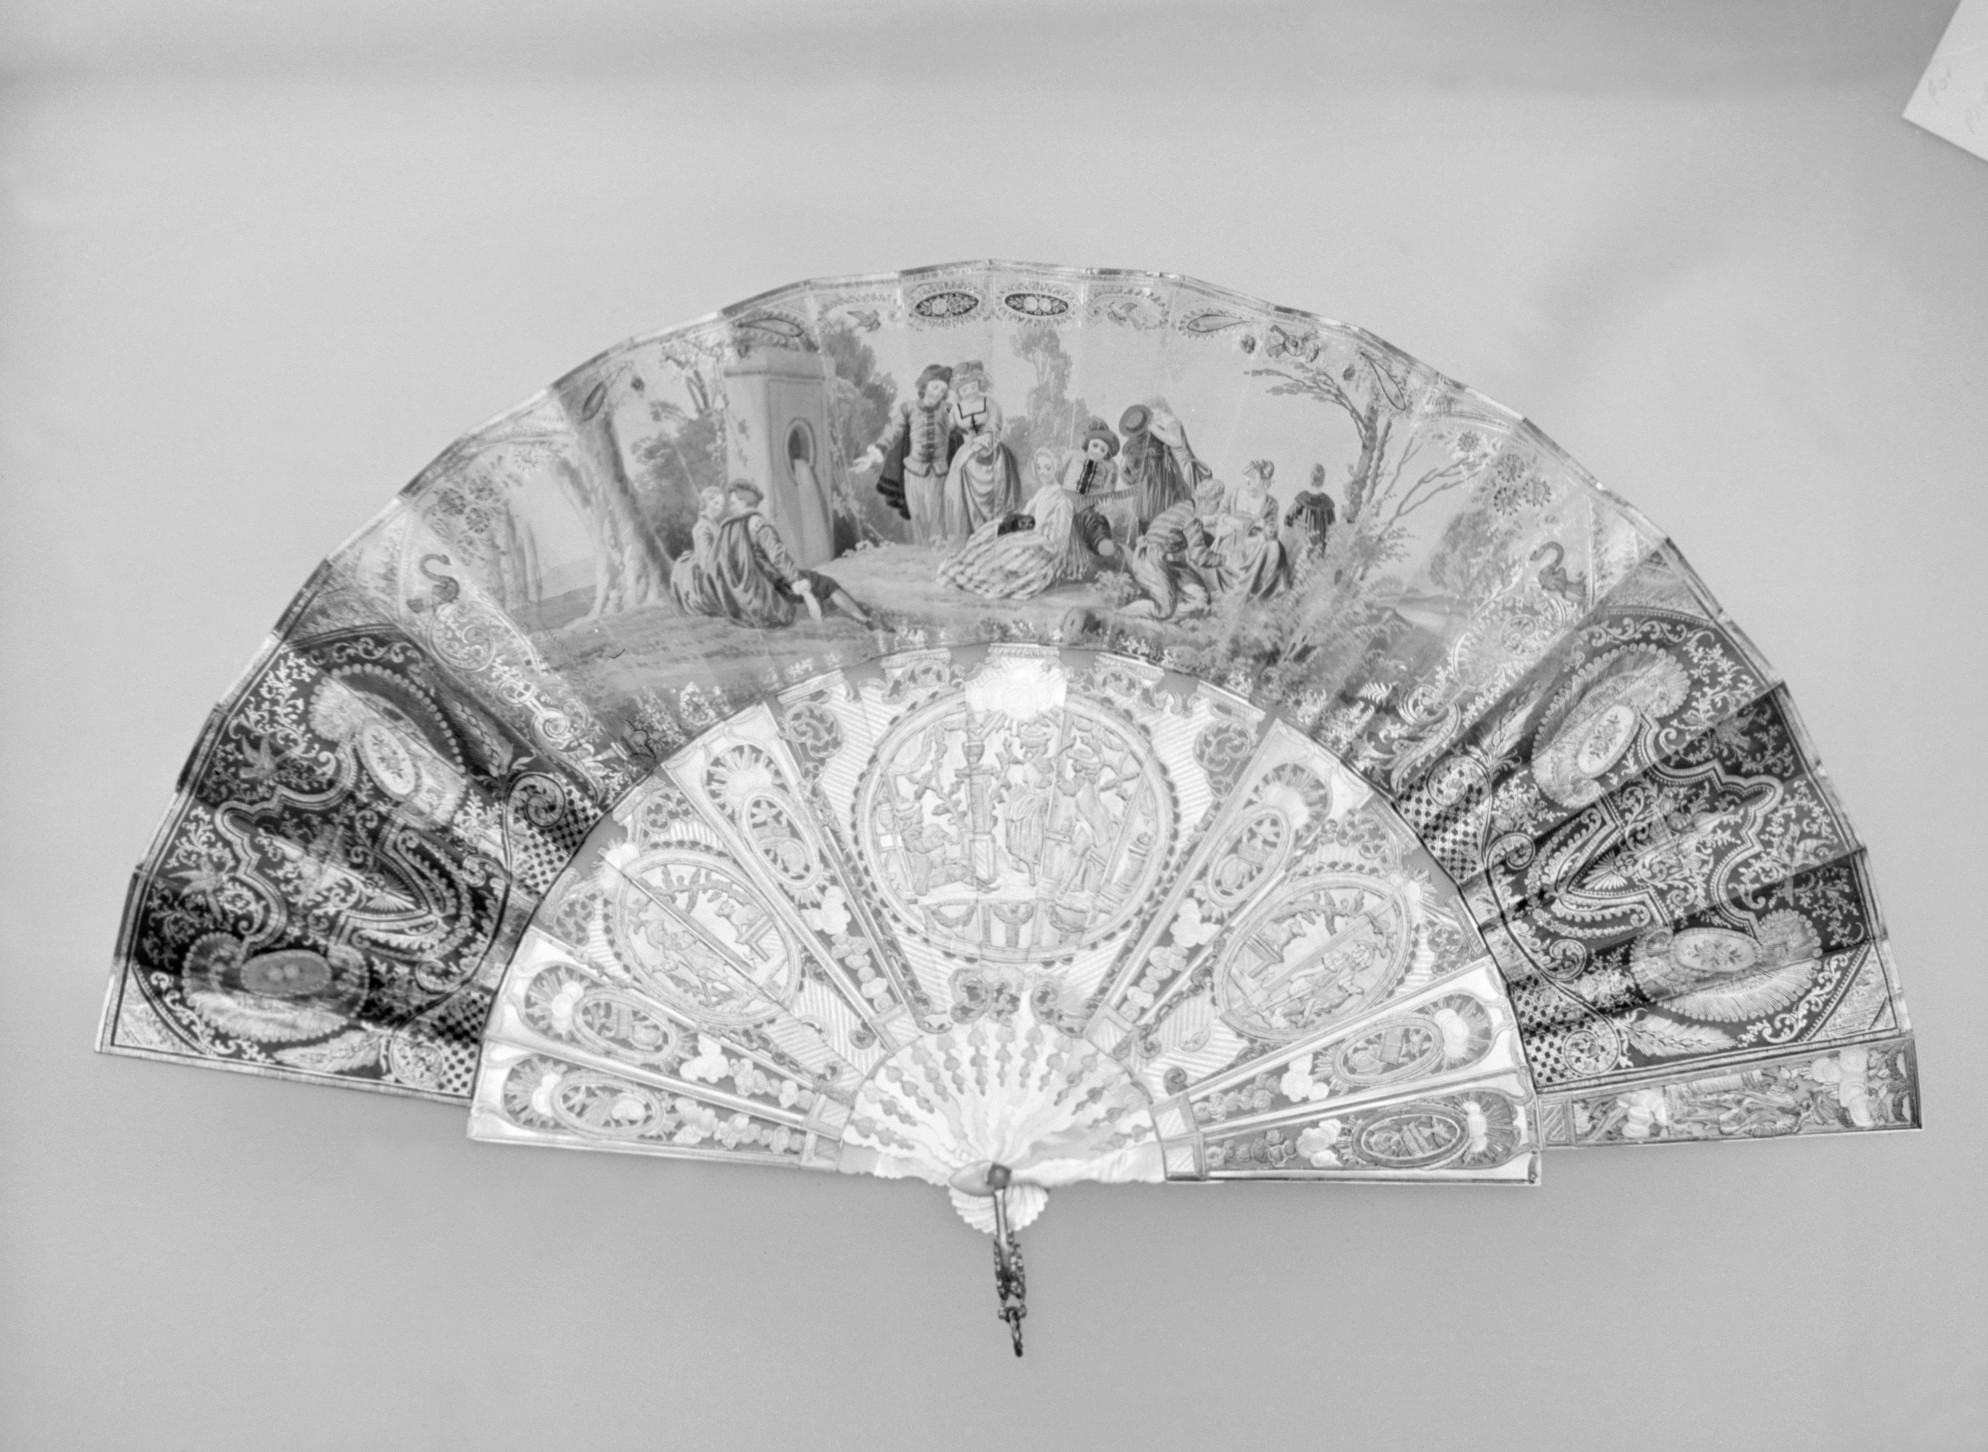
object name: fan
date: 1834-1866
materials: glass, gold, mother of pearl, parchment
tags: men,women